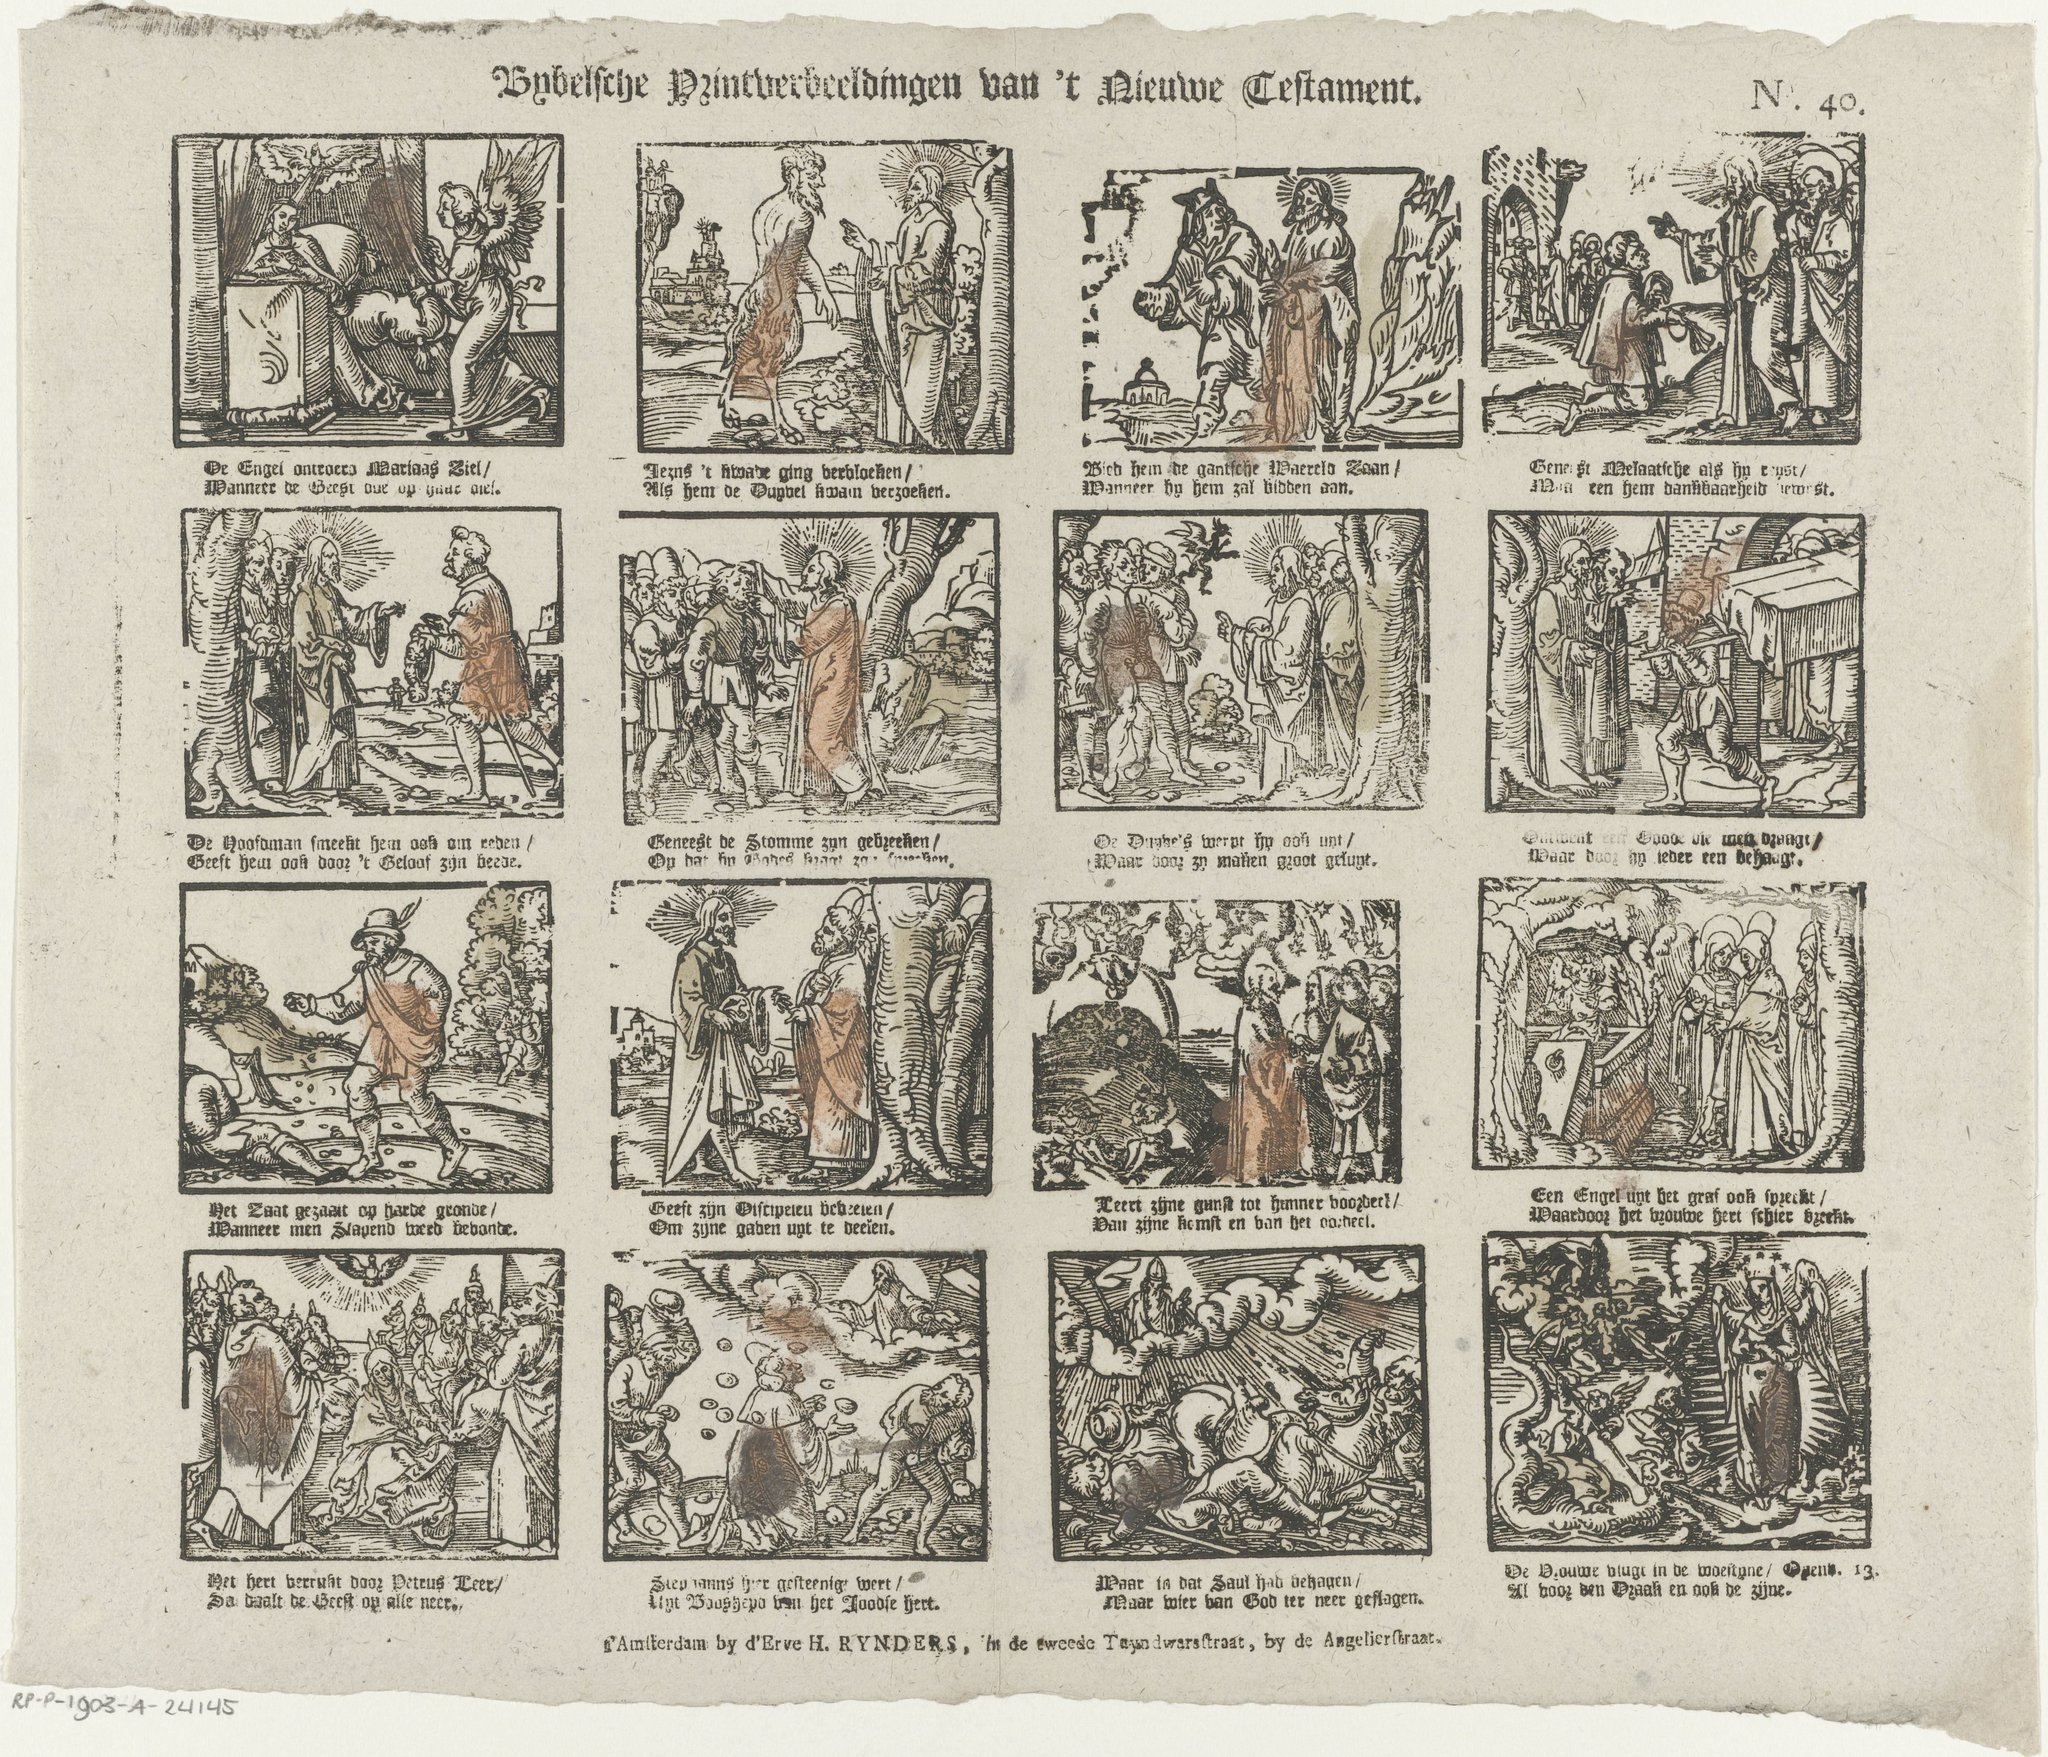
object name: popular print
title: Bybelsche printverbeeldingen van 't Nieuwe Testament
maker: Anonymous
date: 1781-1854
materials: paper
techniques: colour, letterpress printing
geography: netherlands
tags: new testament, the annunciation: mary sitting, series of scenes from the life of christ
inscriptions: collector's mark: Lugt 2228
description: Blad met 16 voorstellingen van verhalen uit het Nieuwe Testament, zoals de Annunciatie en de verzoeking van Christus in de woestijn. Onder elke afbeelding een tweeregelig vers. Genummerd rechtsboven: No. 40.